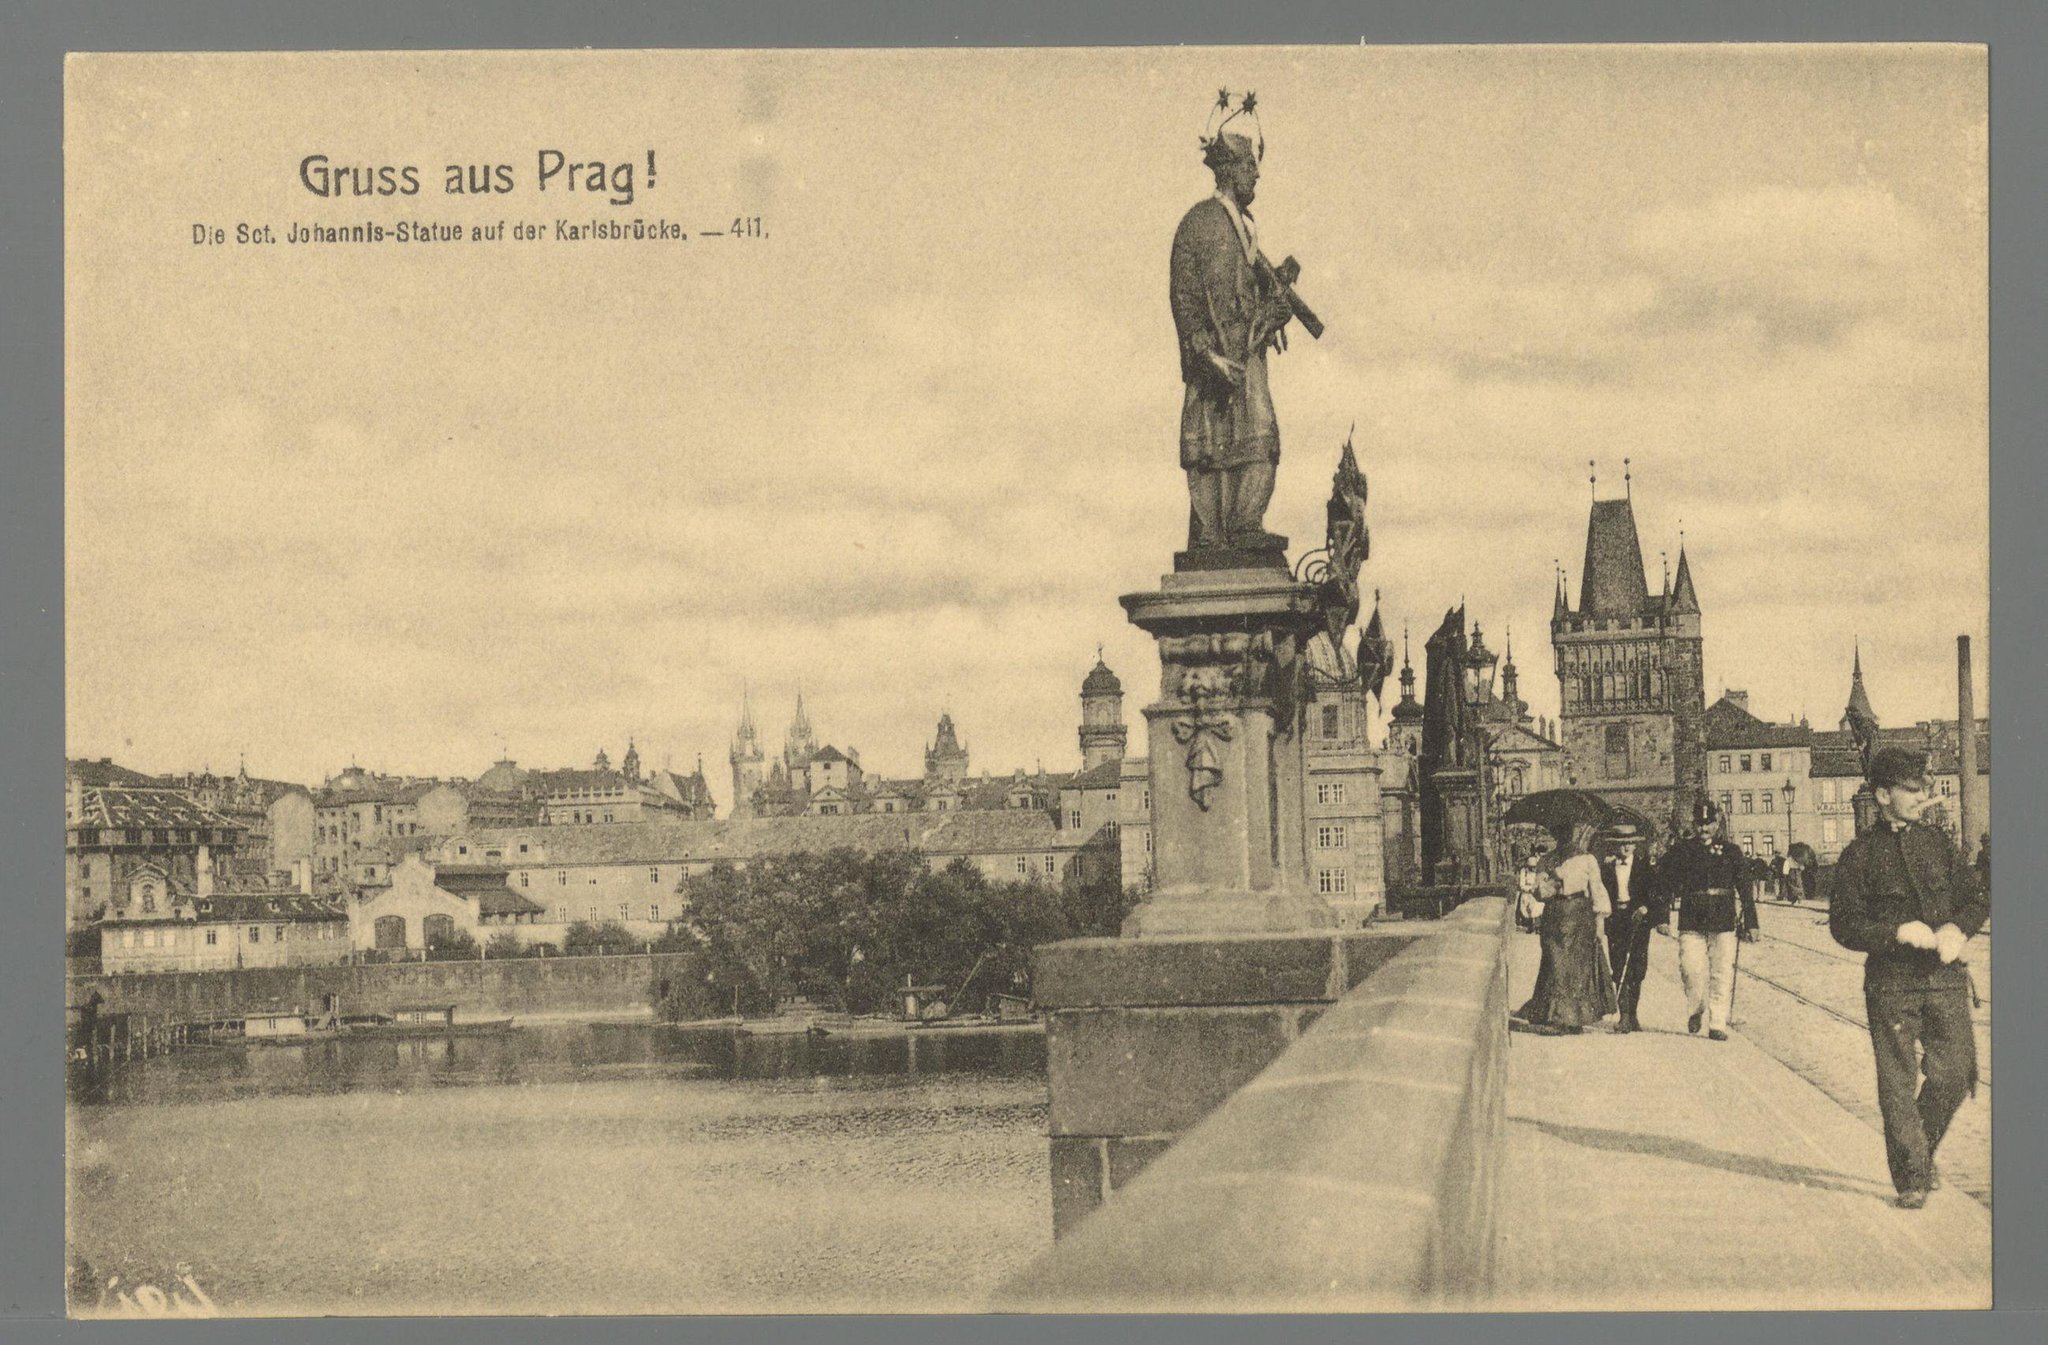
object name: ansichtkaart, prentbriefkaart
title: Gruss aus Prag! Die Sct. Johannis-Statue auf der Karlsbrücke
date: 1908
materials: cardboard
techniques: photograph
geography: prague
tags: monument, statue, canals, waters (in city), bridge in city across river, canal, etc.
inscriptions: date